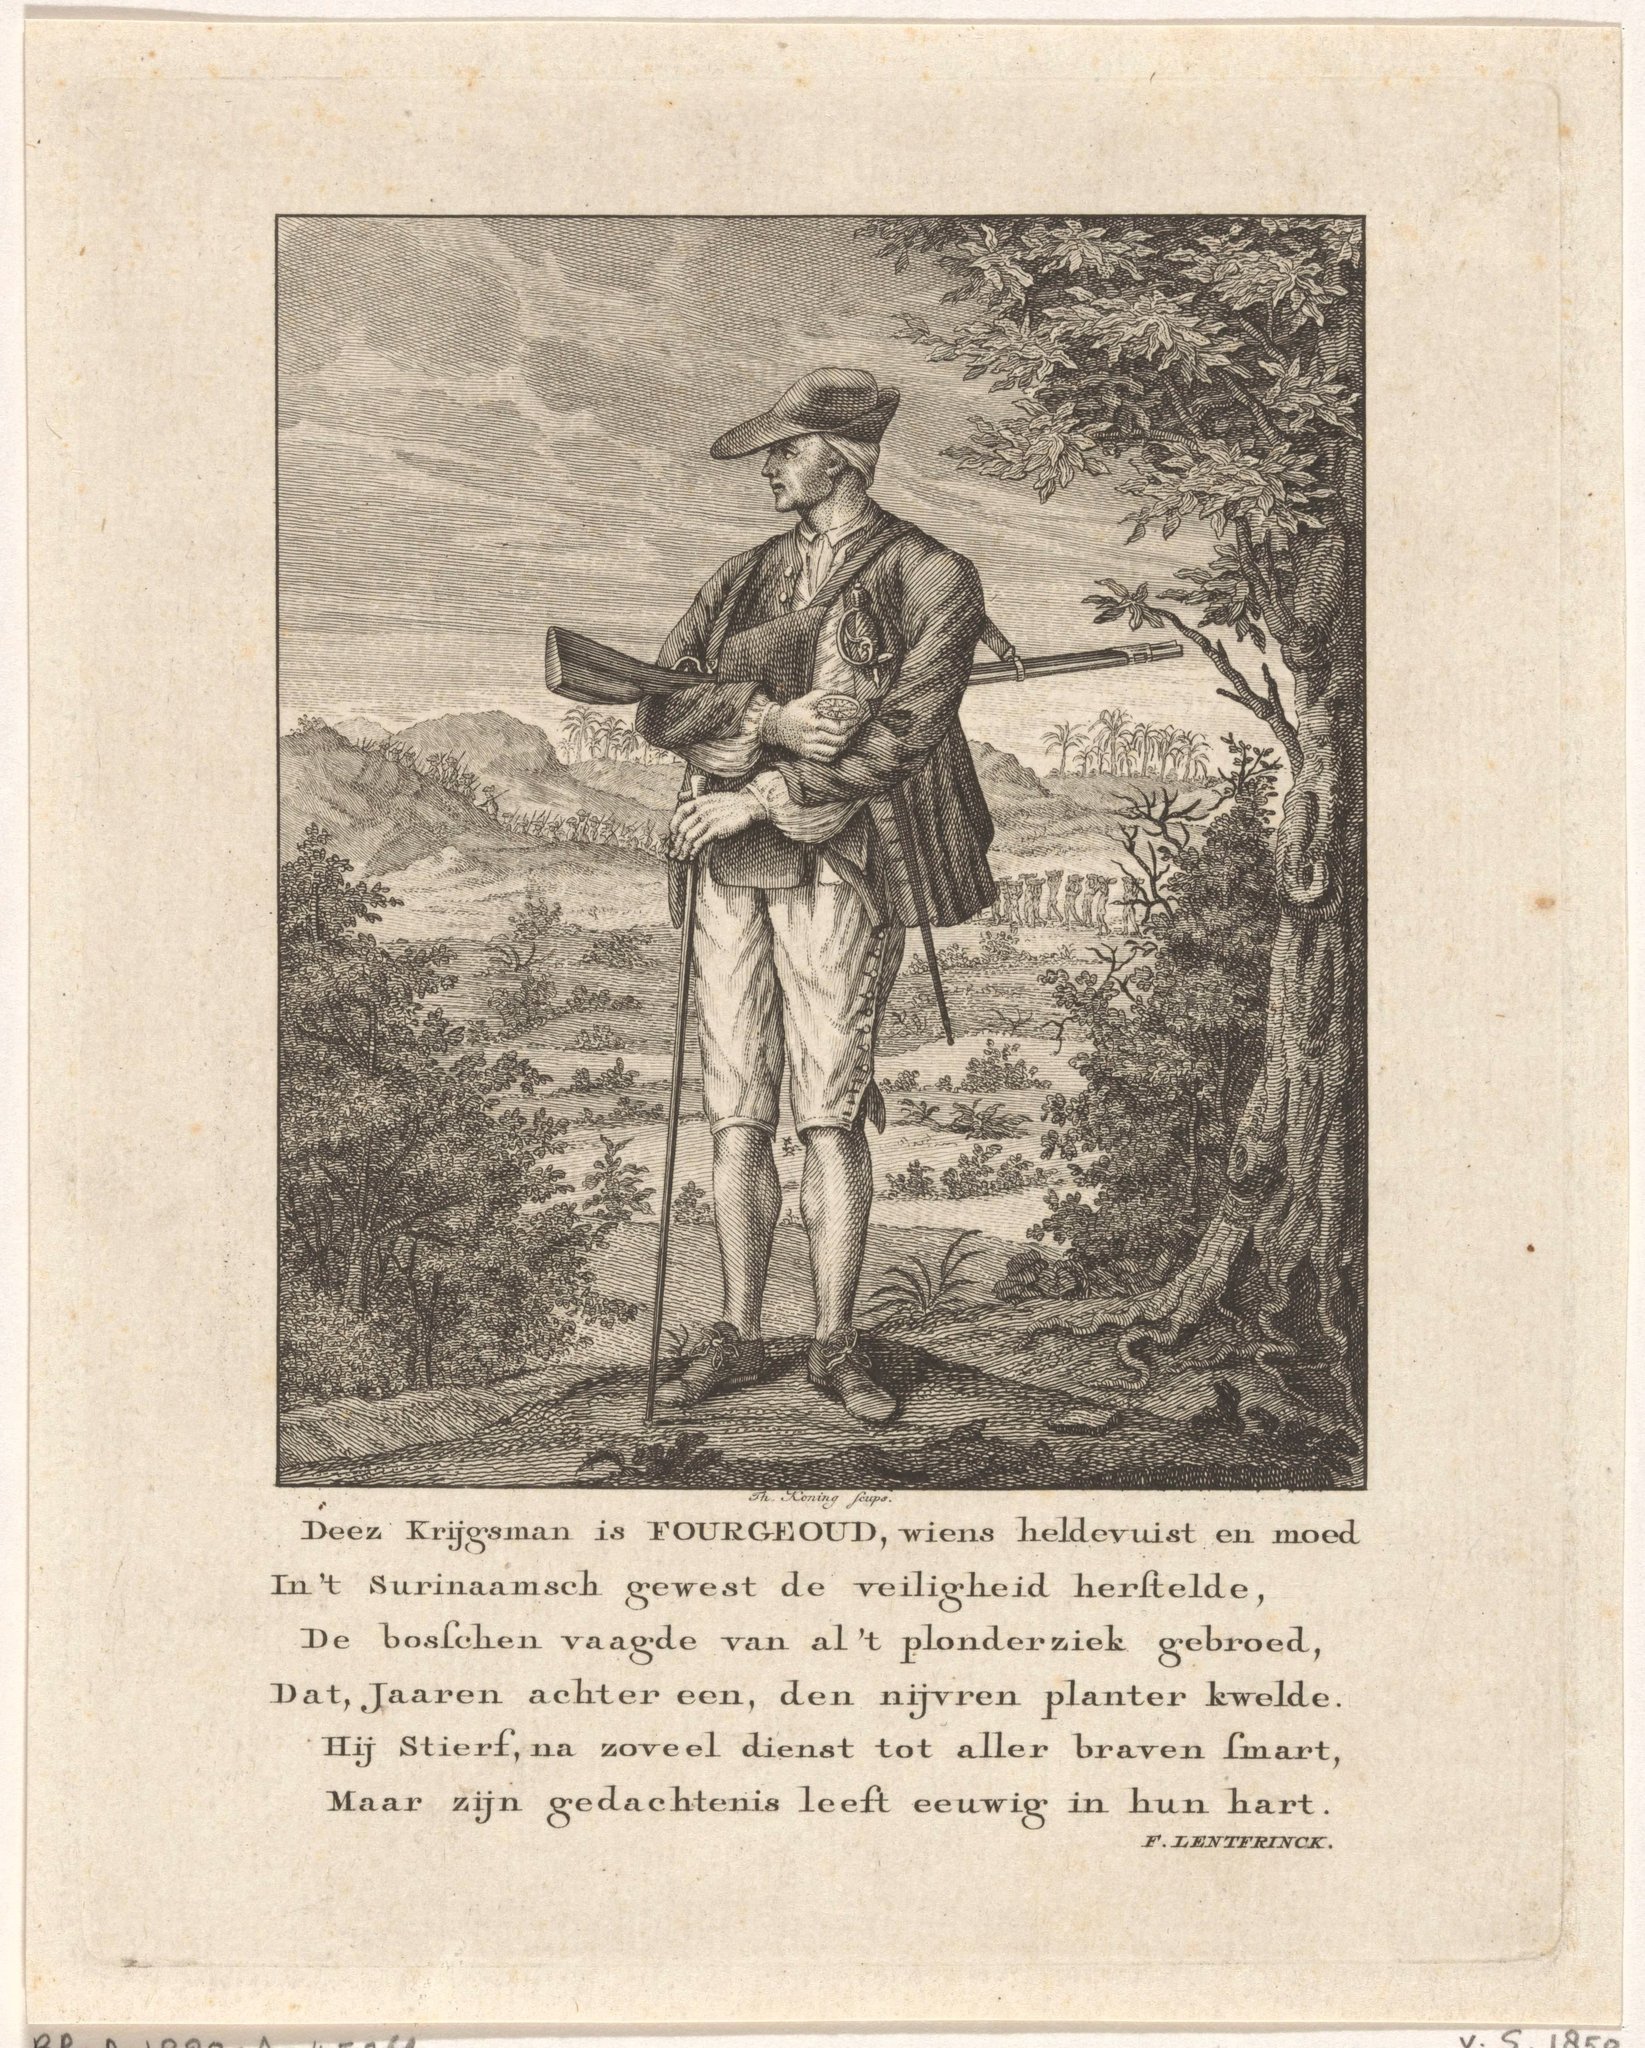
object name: print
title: Portret van kolonel Louis Henri Fourgeoud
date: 1777-1829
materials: paper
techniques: engraving, etching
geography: amsterdam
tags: switzerland, landscapes in tropical and sub-tropical regions - kk - ideal landscapes, colonial system, compass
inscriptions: collector's mark: Lugt 2228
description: Portret ten voeten uit van kolonel Louis Henry Fourgeoud, staande in een heuvelachtig landschap met palmbomen. Fourgeoud draagt een geweer, een degen en een kompas en leunt op zijn wandelstok. Op de achtergrond figuren met wapens en manden.